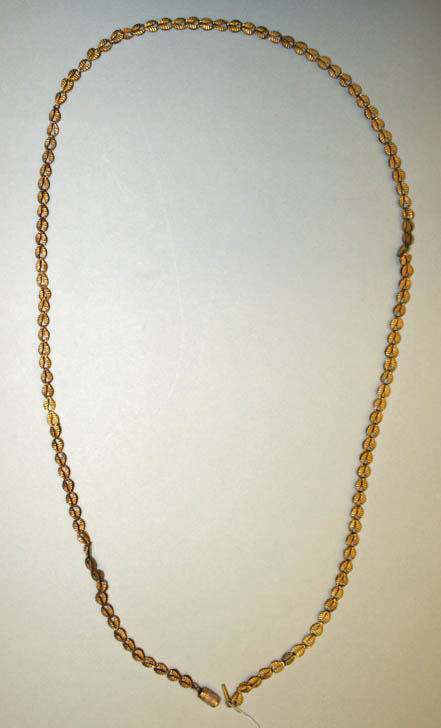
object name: necklace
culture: french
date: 1801-1900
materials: metal